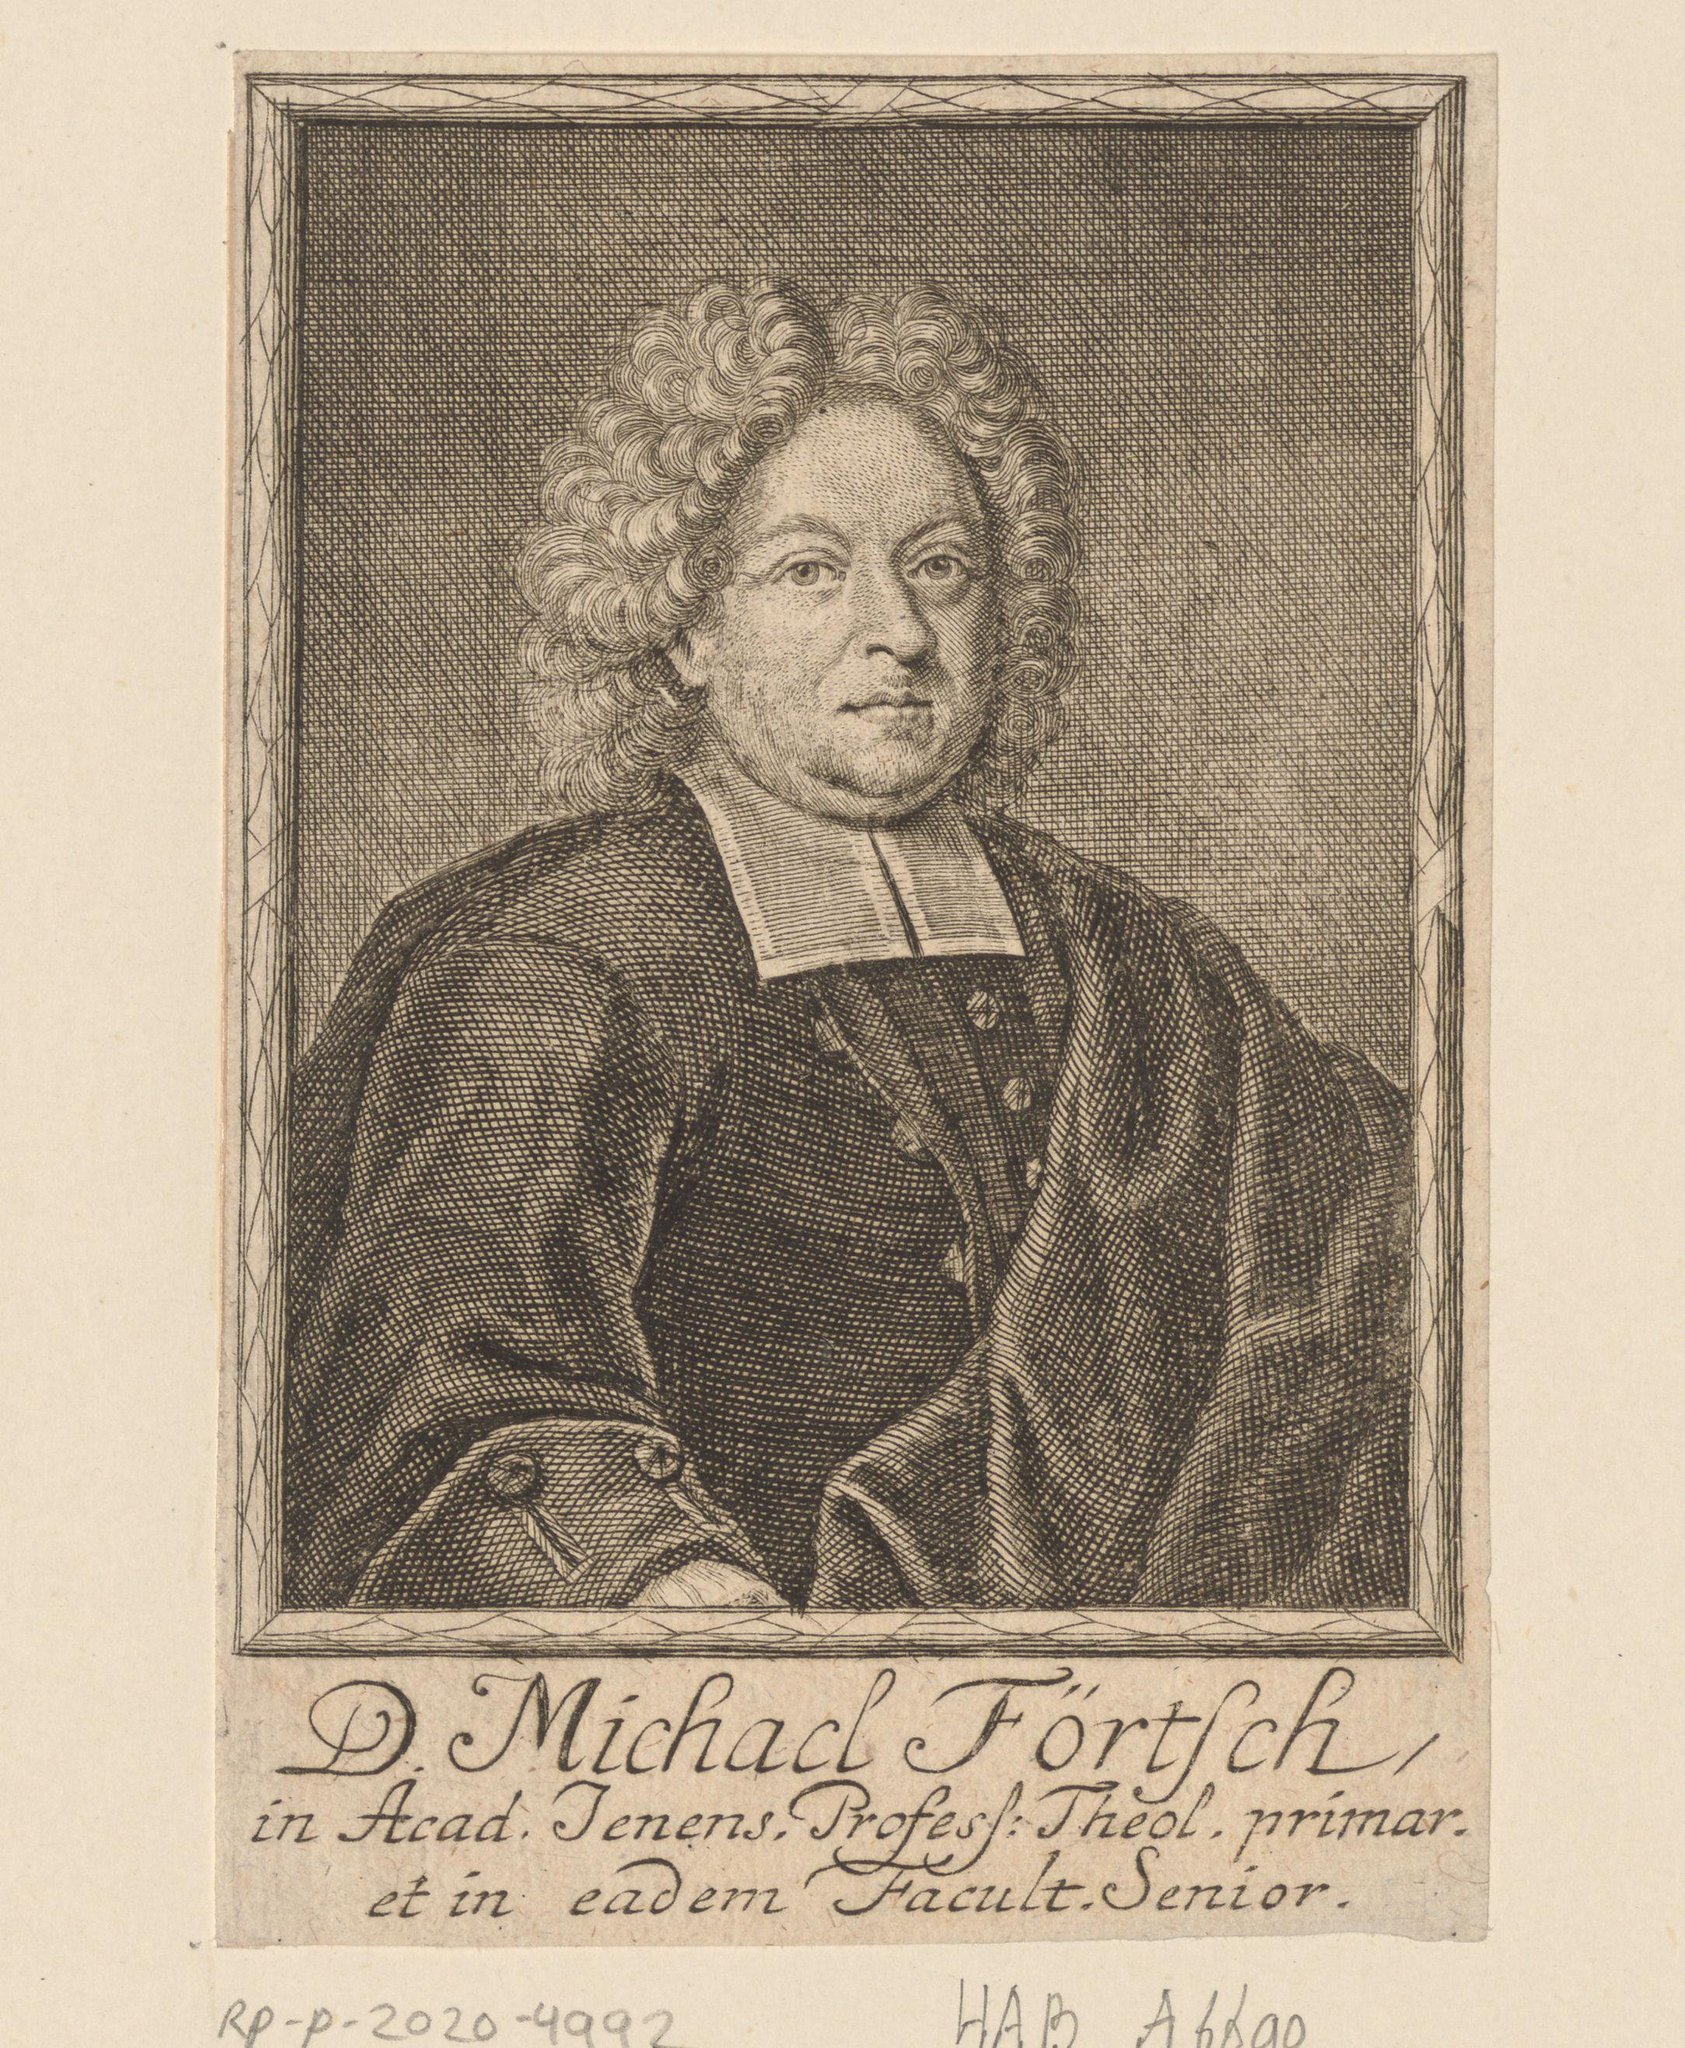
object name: print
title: Portret van Michael Förtsch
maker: johann georg mentzel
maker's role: print maker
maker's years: 1677-1743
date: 1705-1724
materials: paper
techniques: engraving, etching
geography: germany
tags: theologian, historical persons, professor